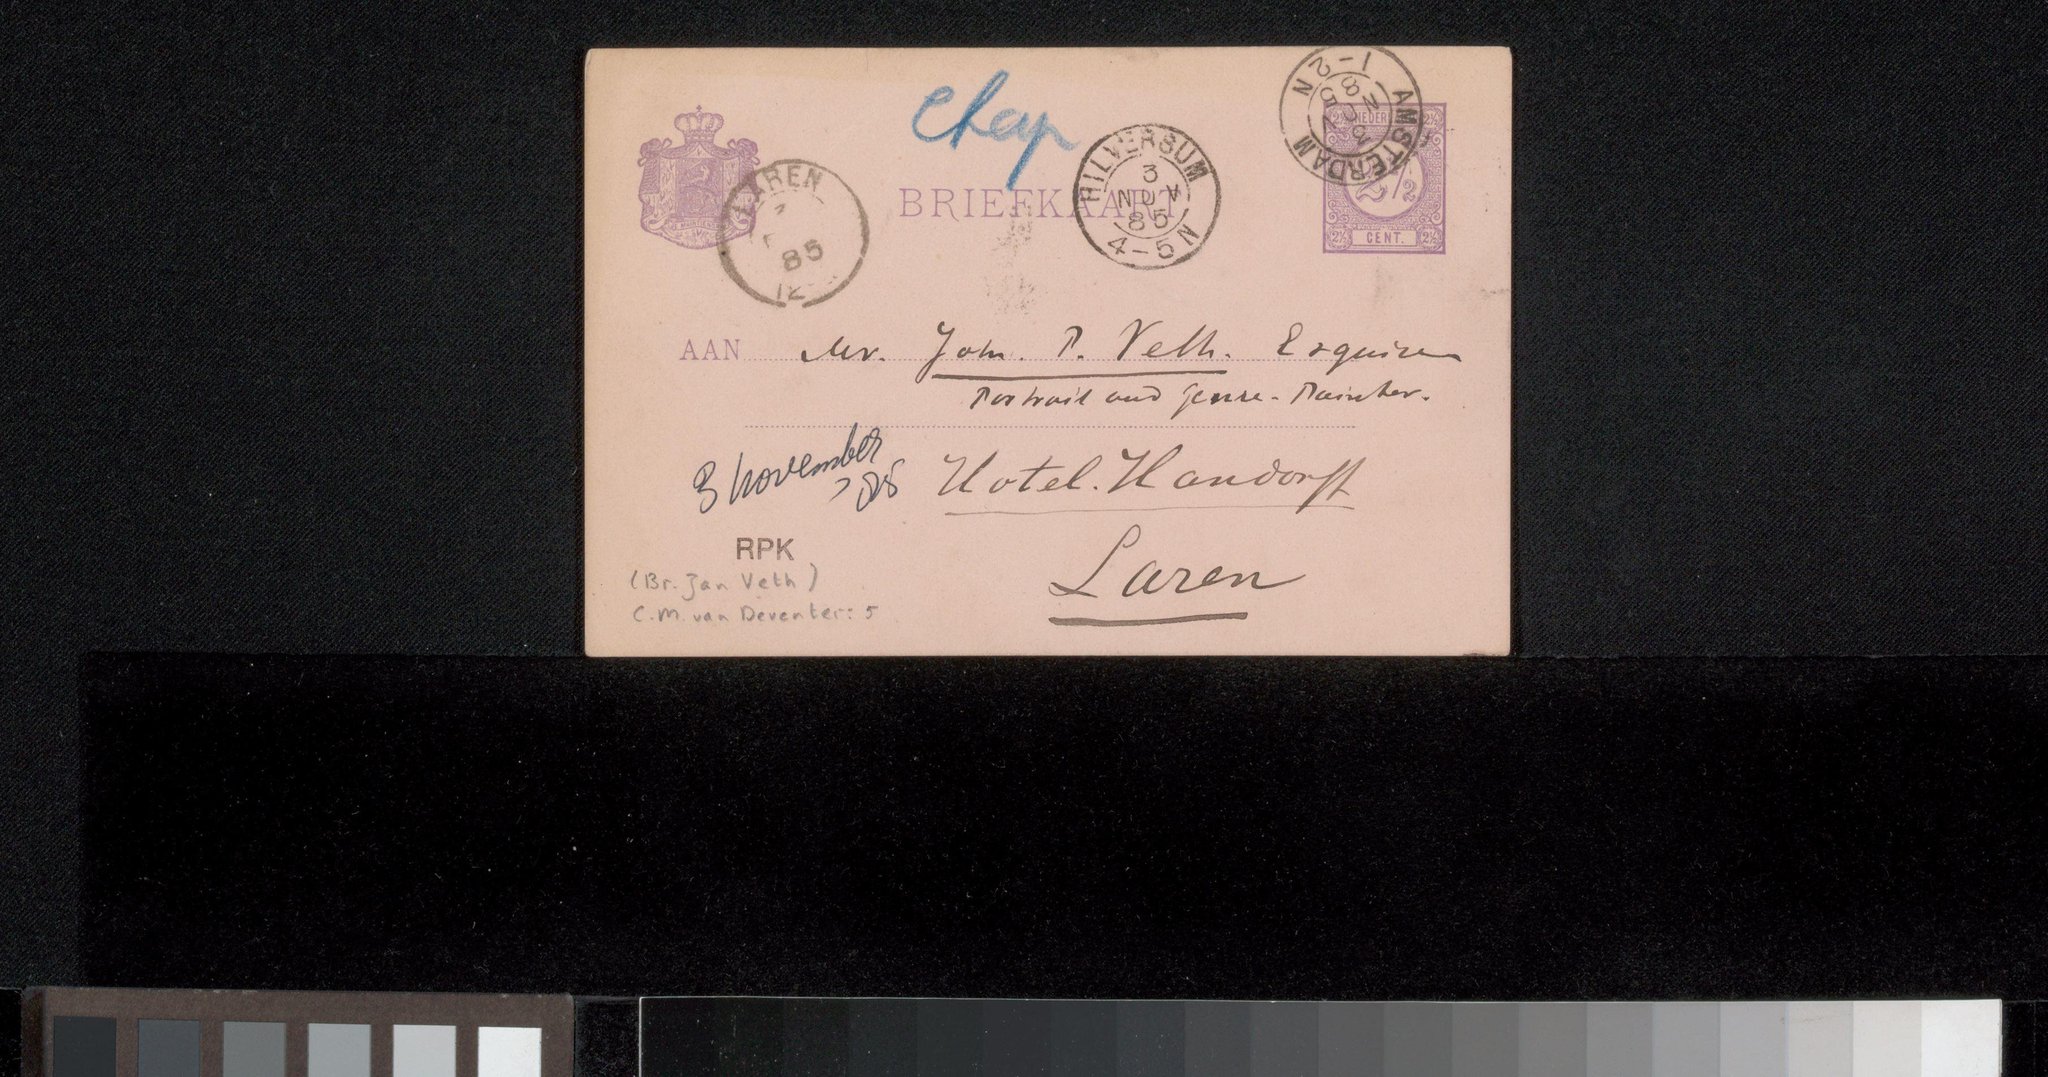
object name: postcard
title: Briefkaart aan Jan Veth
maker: chap van deventer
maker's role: kunstcriticus, scheikundige, schrijver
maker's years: 1860-1931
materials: cardboard, ink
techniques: pen, writing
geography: amsterdam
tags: dordrecht, amsterdam, painter, print maker, draughtsman, designer, jan veth, literature ~ arts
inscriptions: collector's mark: ‘RPK’